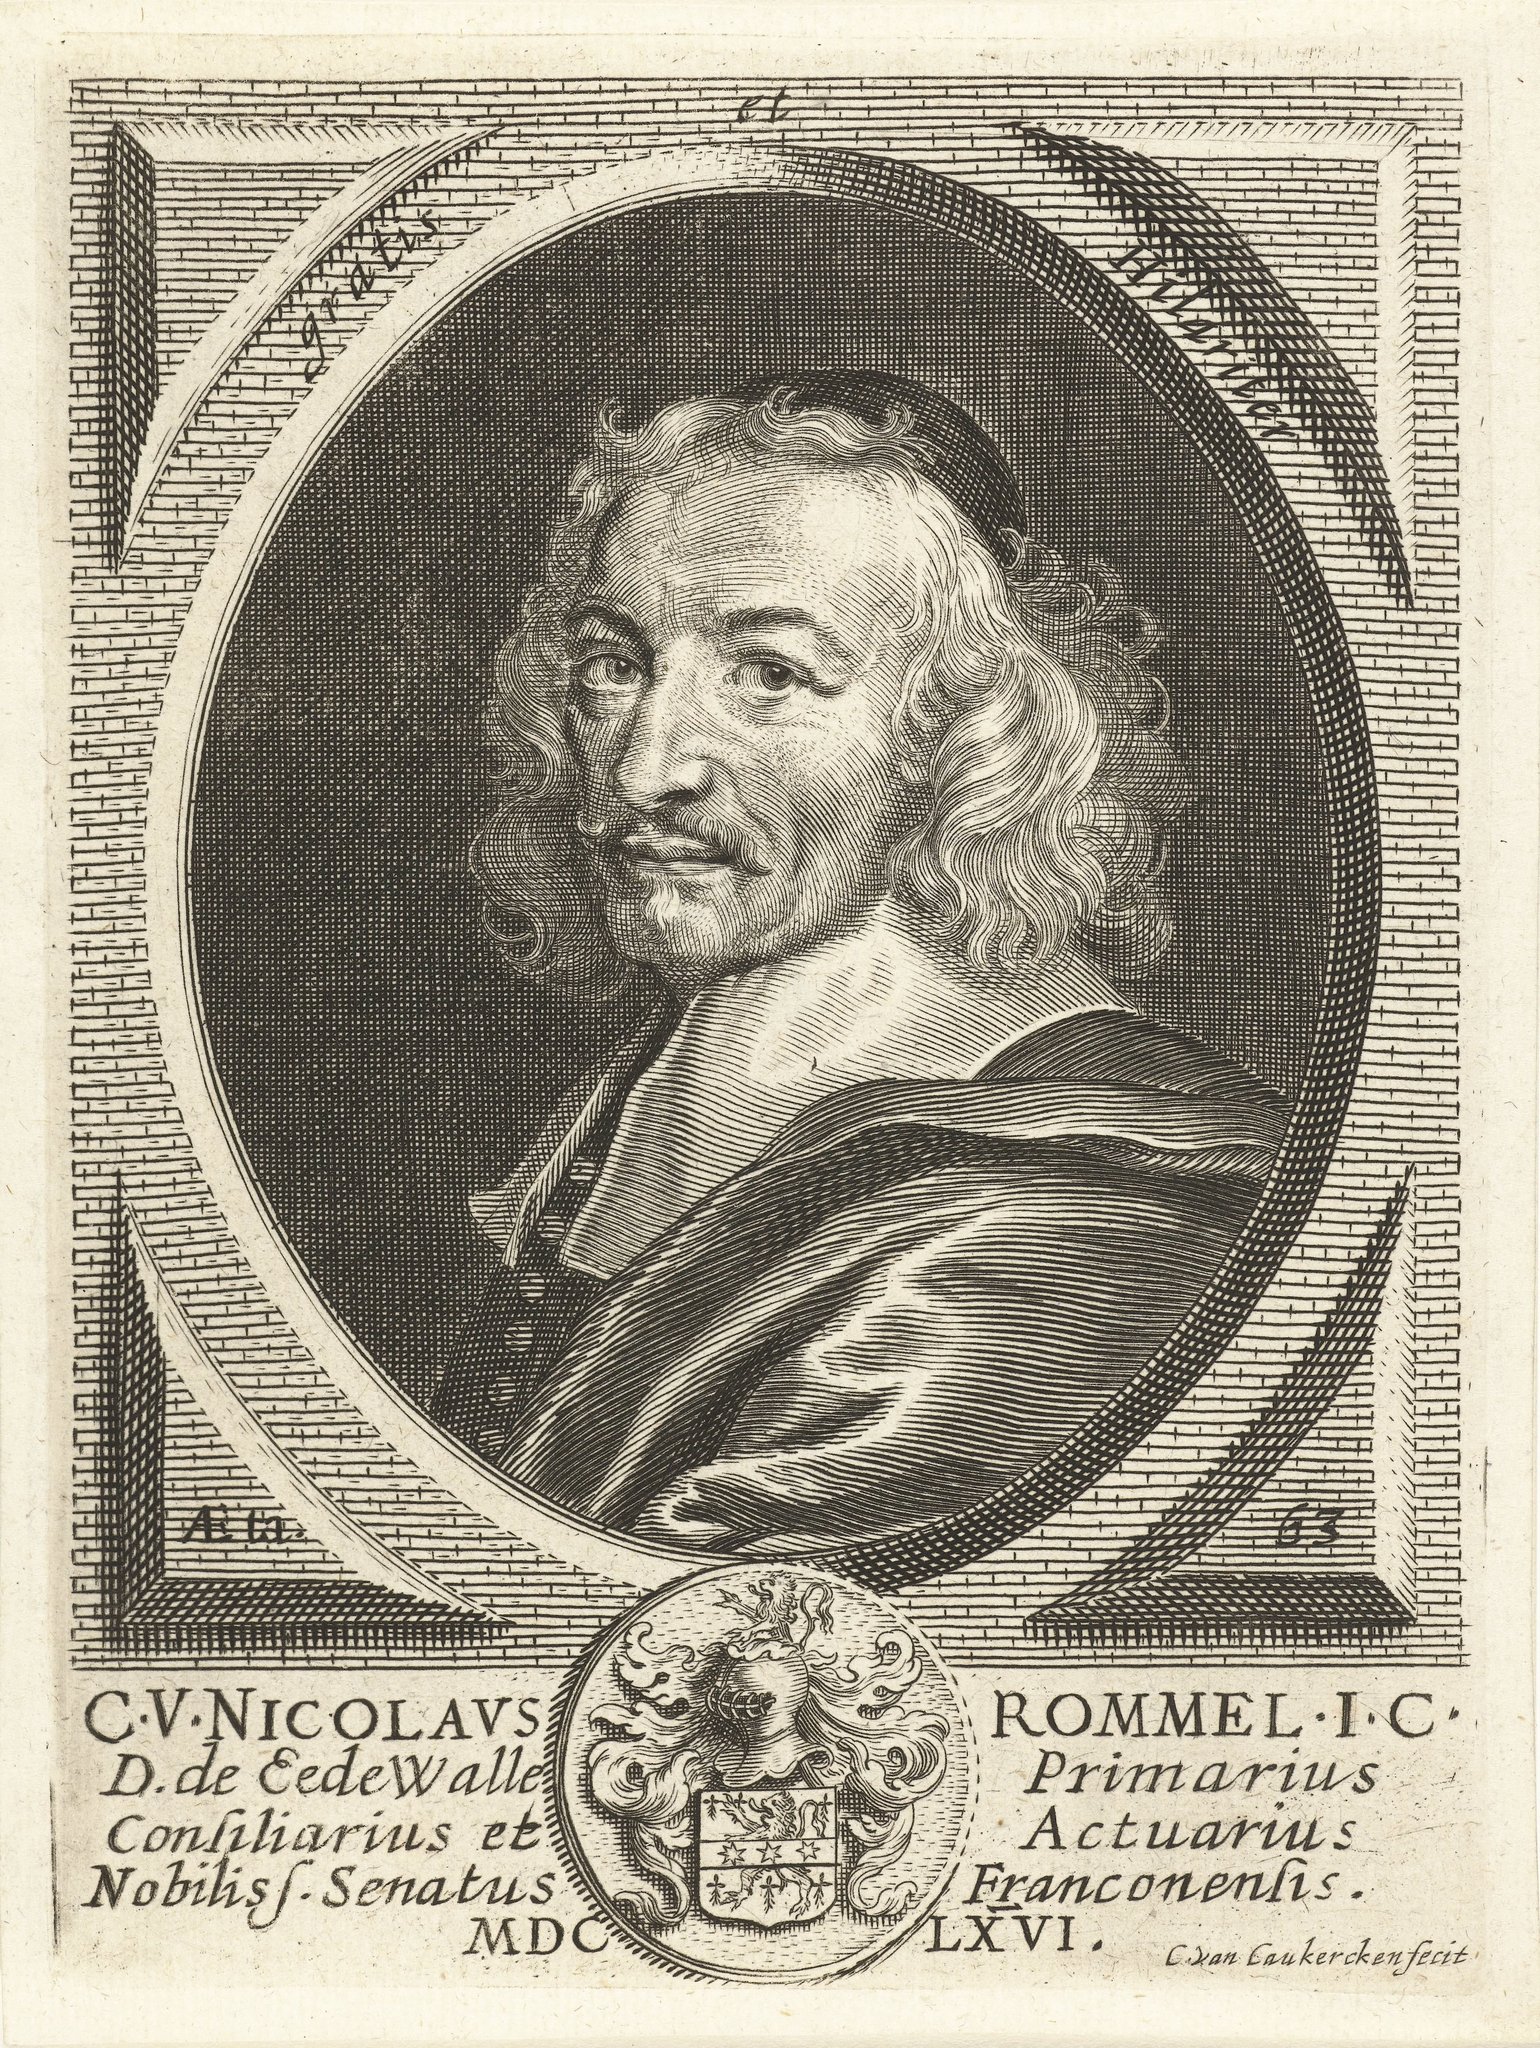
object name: print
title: Portret van Nicolaas Rommel op 63-jarige leeftijd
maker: cornelis van caukercken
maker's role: print maker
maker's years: 1626-1680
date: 1640-1680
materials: paper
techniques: engraving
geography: southern netherlands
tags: nicolaas rommel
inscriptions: collector's mark: Lugt 2228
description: Portret van Nicolaas Rommel op 63-jarige leeftijd. In de marge zijn motto: Gratis et hilariter.